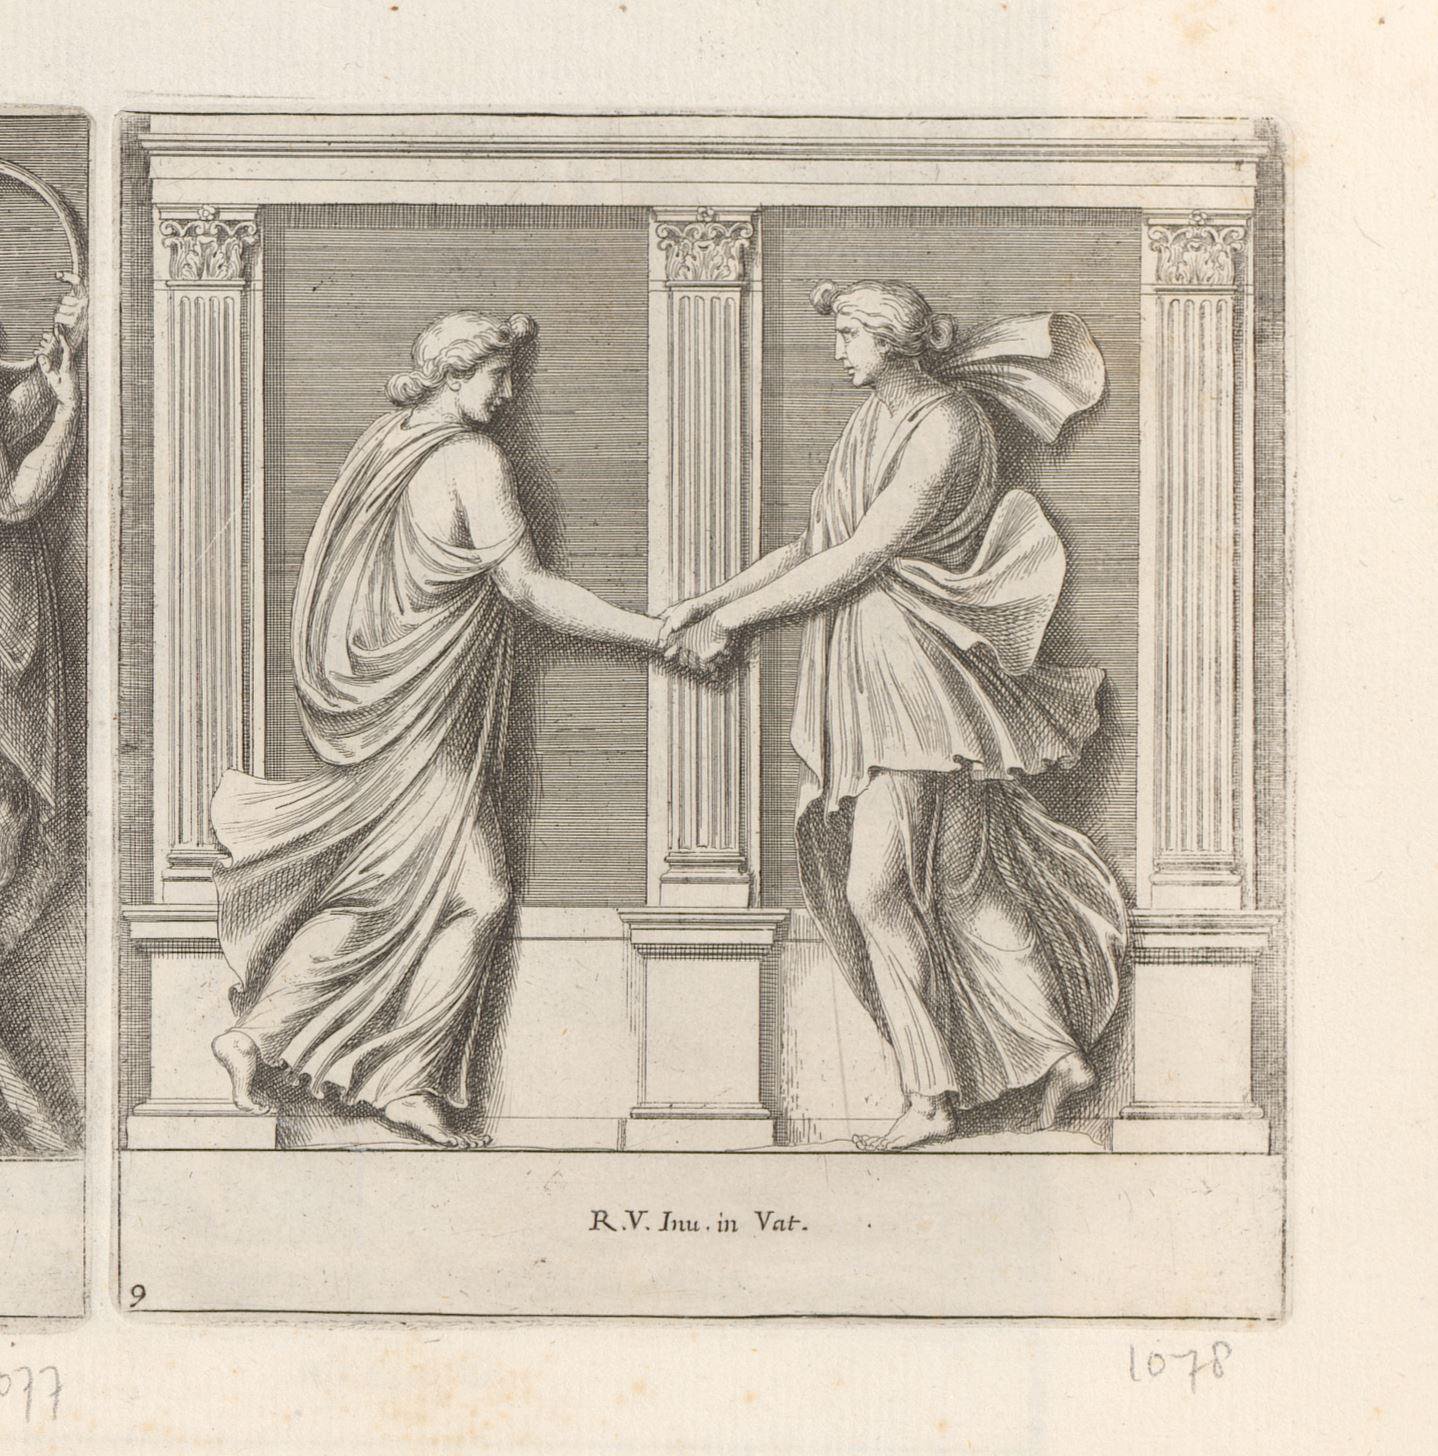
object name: album leaf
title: Twee dansende figuren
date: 1645-1700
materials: paper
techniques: engraving, etching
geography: italy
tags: adult woman, dancing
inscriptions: number: ‘40’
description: Prent uit een reeks naar de gipsen reliëfs door Rafaël en uitgevoerd door zijn assistenten in de Vaticaanse Loggia.